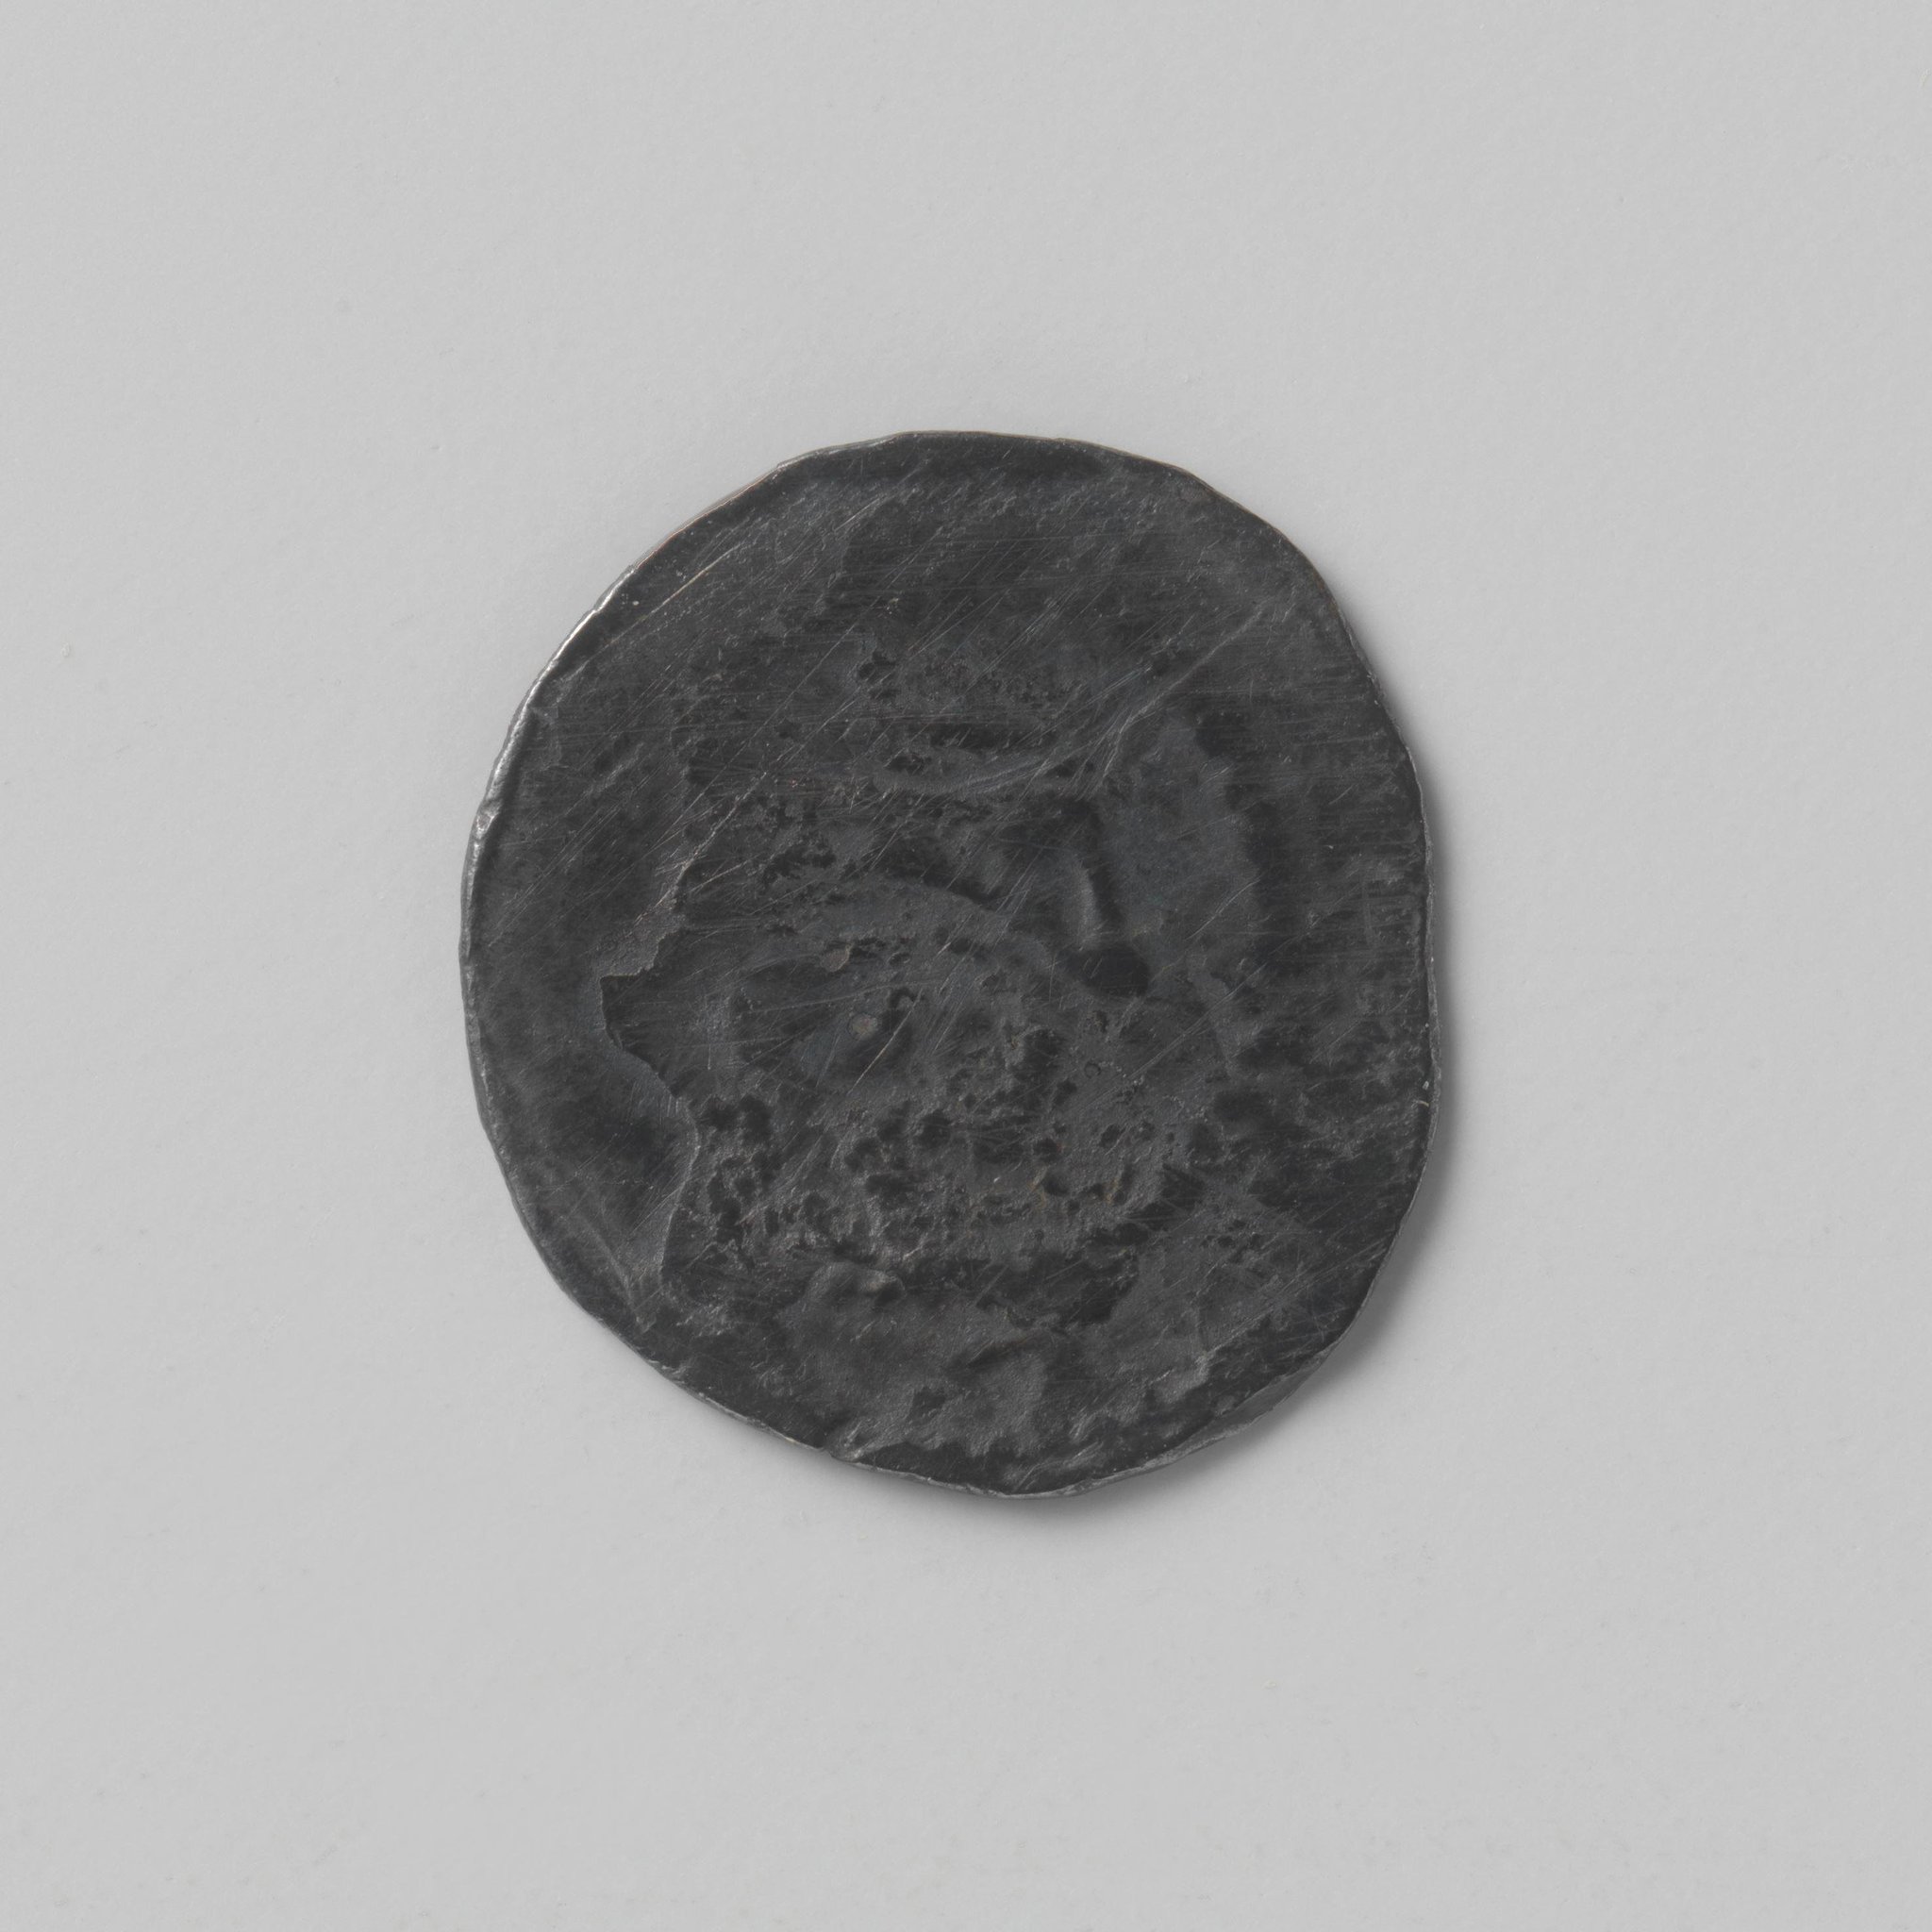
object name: penny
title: Holland, Floris V, penning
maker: floris v (graaf van holland en zeeland)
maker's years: 1254-1296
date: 1256-1258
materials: silver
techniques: striking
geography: dordrecht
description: Zilveren munt. Voorzijde: hoofd met gravenmuts naar rechts. Keerzijde: lang dubellijnig kruis.